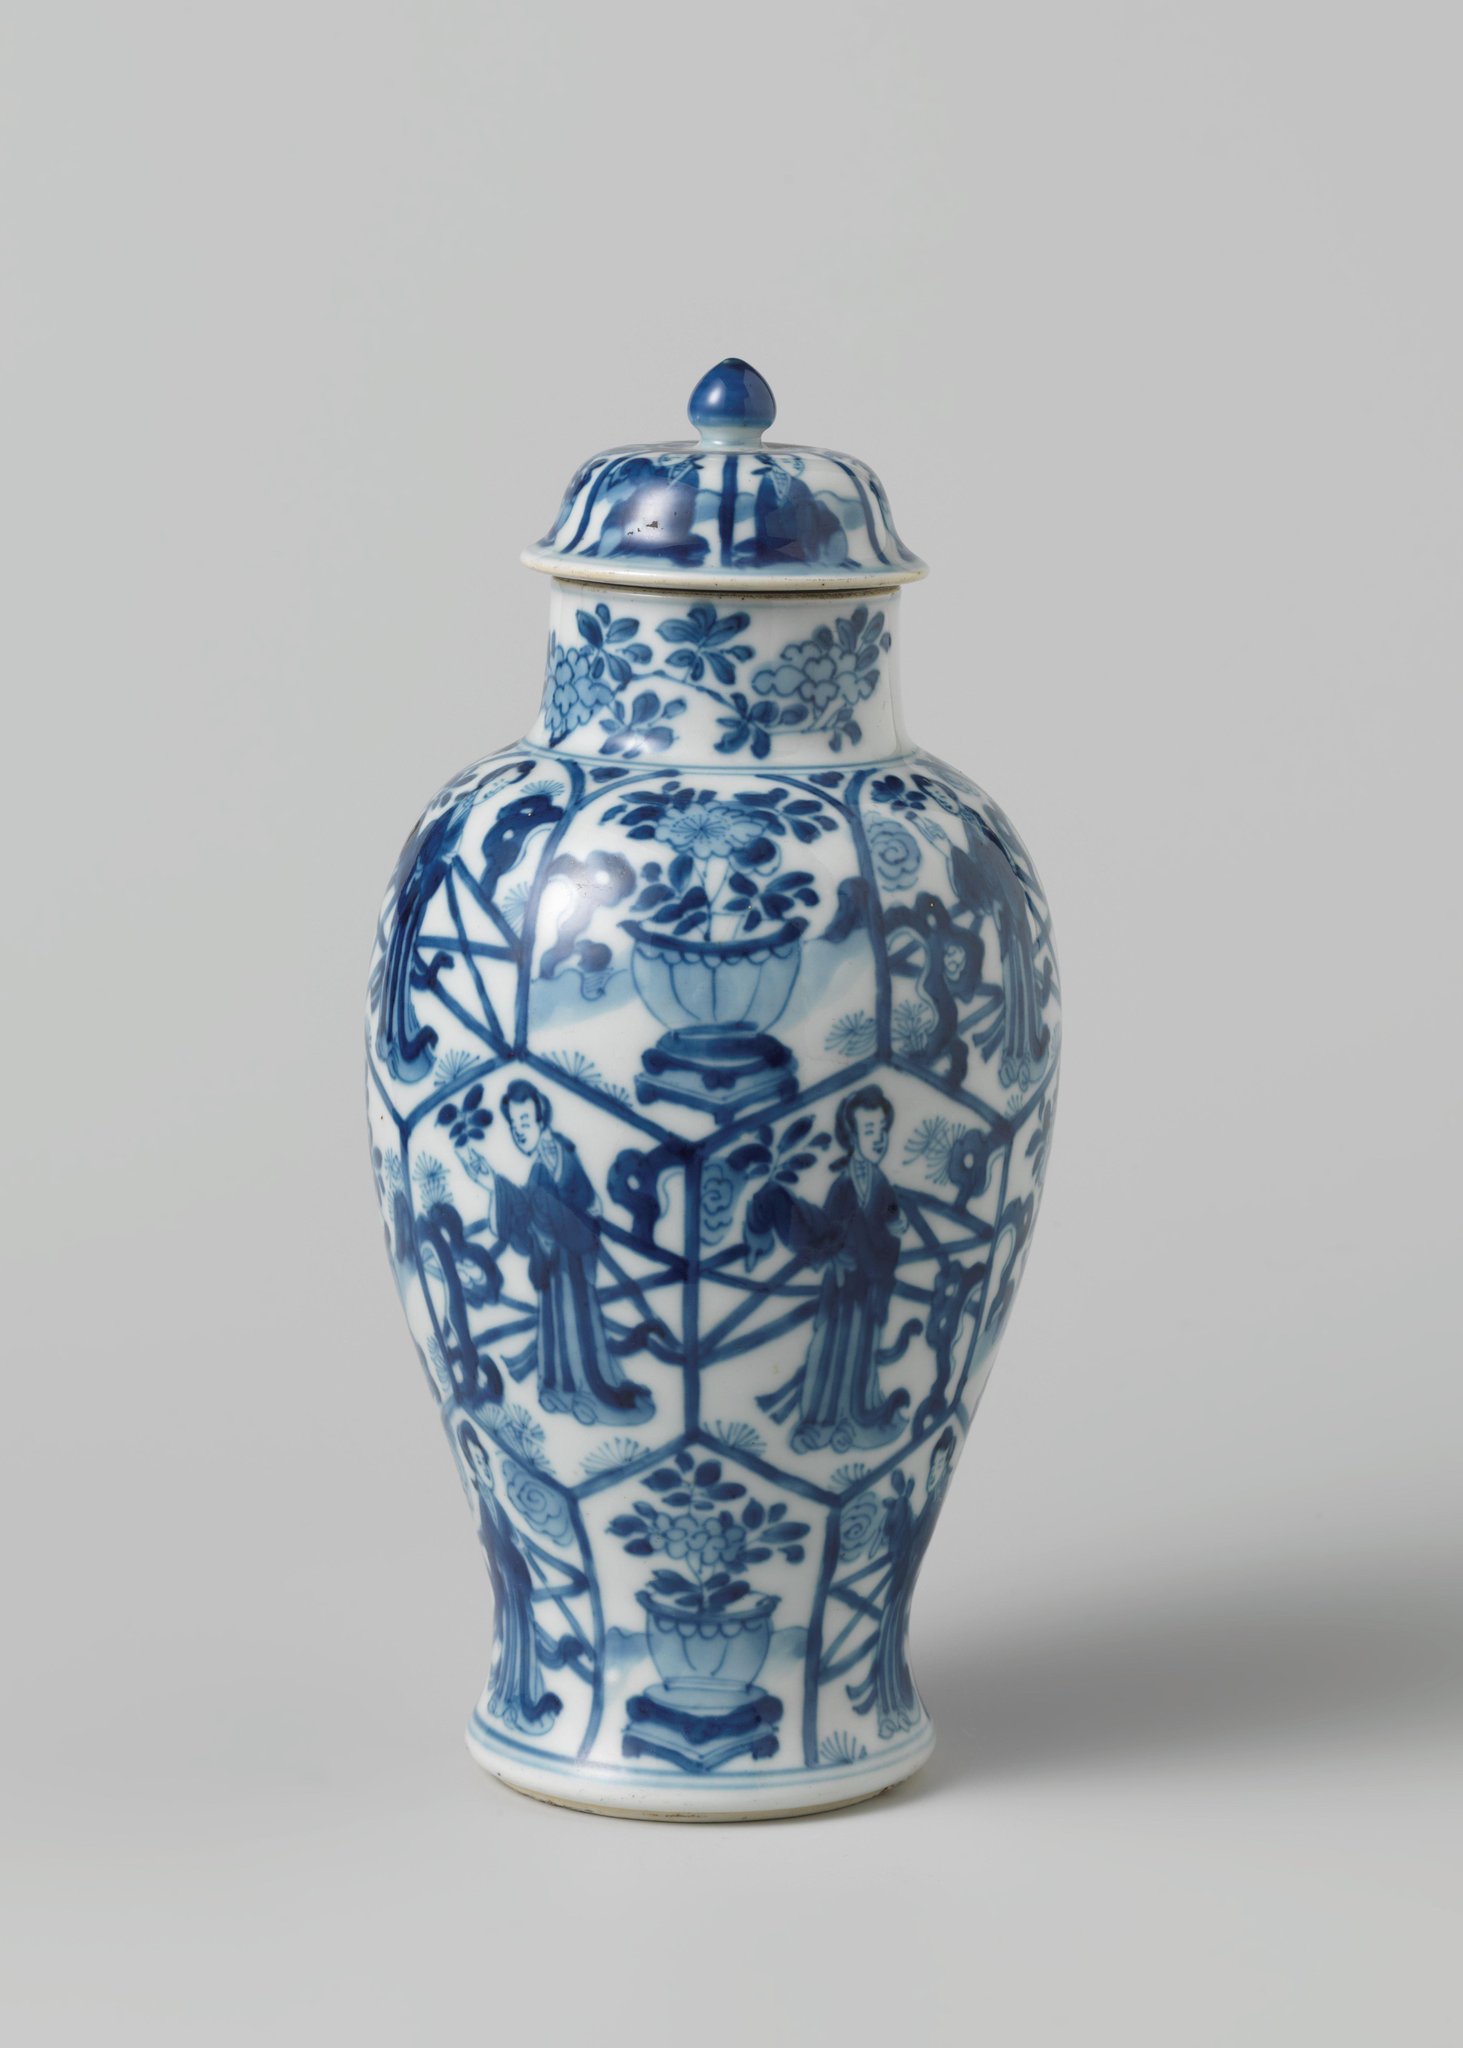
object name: covered jar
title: Covered jar with women and flower pots in panels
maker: Anonymous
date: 1680-1720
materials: cobalt, glaze, paint, porcelain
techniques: firing, turning, vitrification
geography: china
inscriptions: mark: ‘玉 Yù’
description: Balustervormige dekselpot van porselein, beschilderd in onderglazuur blauw. De wand is verdeeld in drie rijen met zeshoekige vakken met daarin afwisselend een vrouw (lange lijs) in een omheinde tuin en een bloemenvaas in een landschap. Op de schouder twee bloemtakken. Gemerkt op de onderzijde met het karakter 'yù', jade, in een dubbele cirkel. Een barst in de rand. Onderdeel van een kaststel met nummer AK-RBK-16290. Blauw-wit.